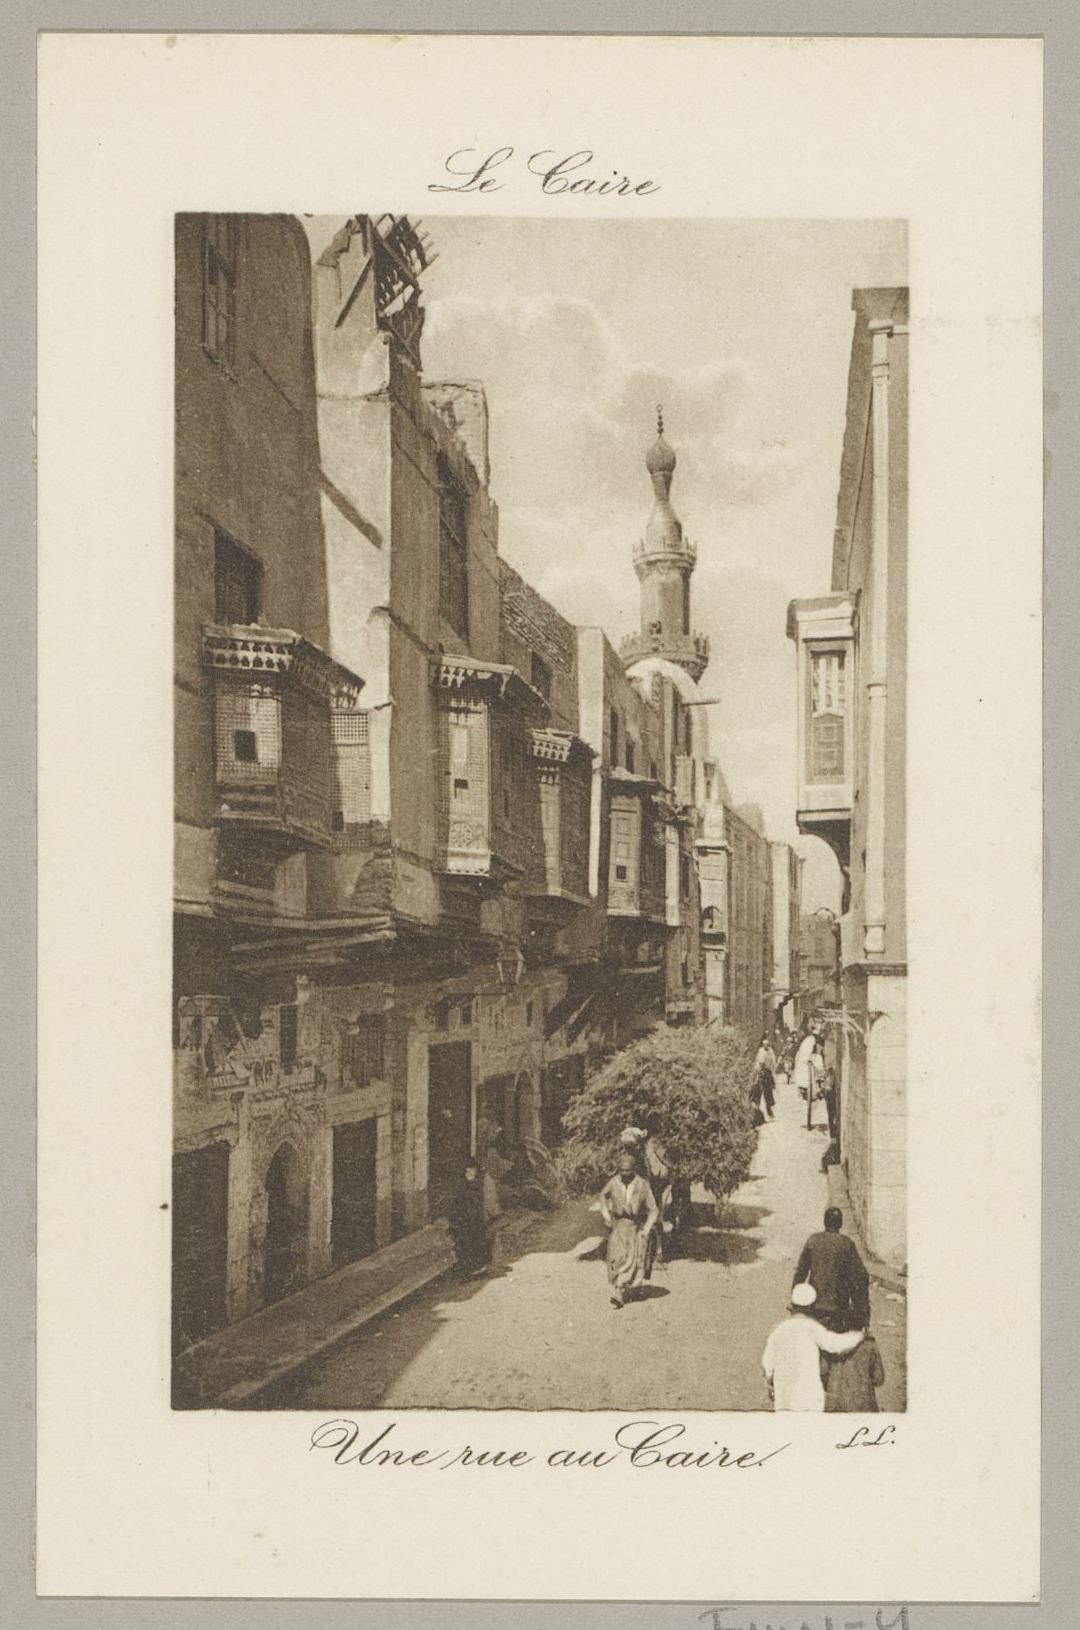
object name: photomechanical print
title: Straatgezicht in Caïro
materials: paper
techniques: photograph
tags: temple, shrine ~ islam, mohammedanism, street (+ city(-scape) with figures, staffage)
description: Onderdeel van Fotoalbum van een reis door Zuid-Europa en het Midden-Oosten.